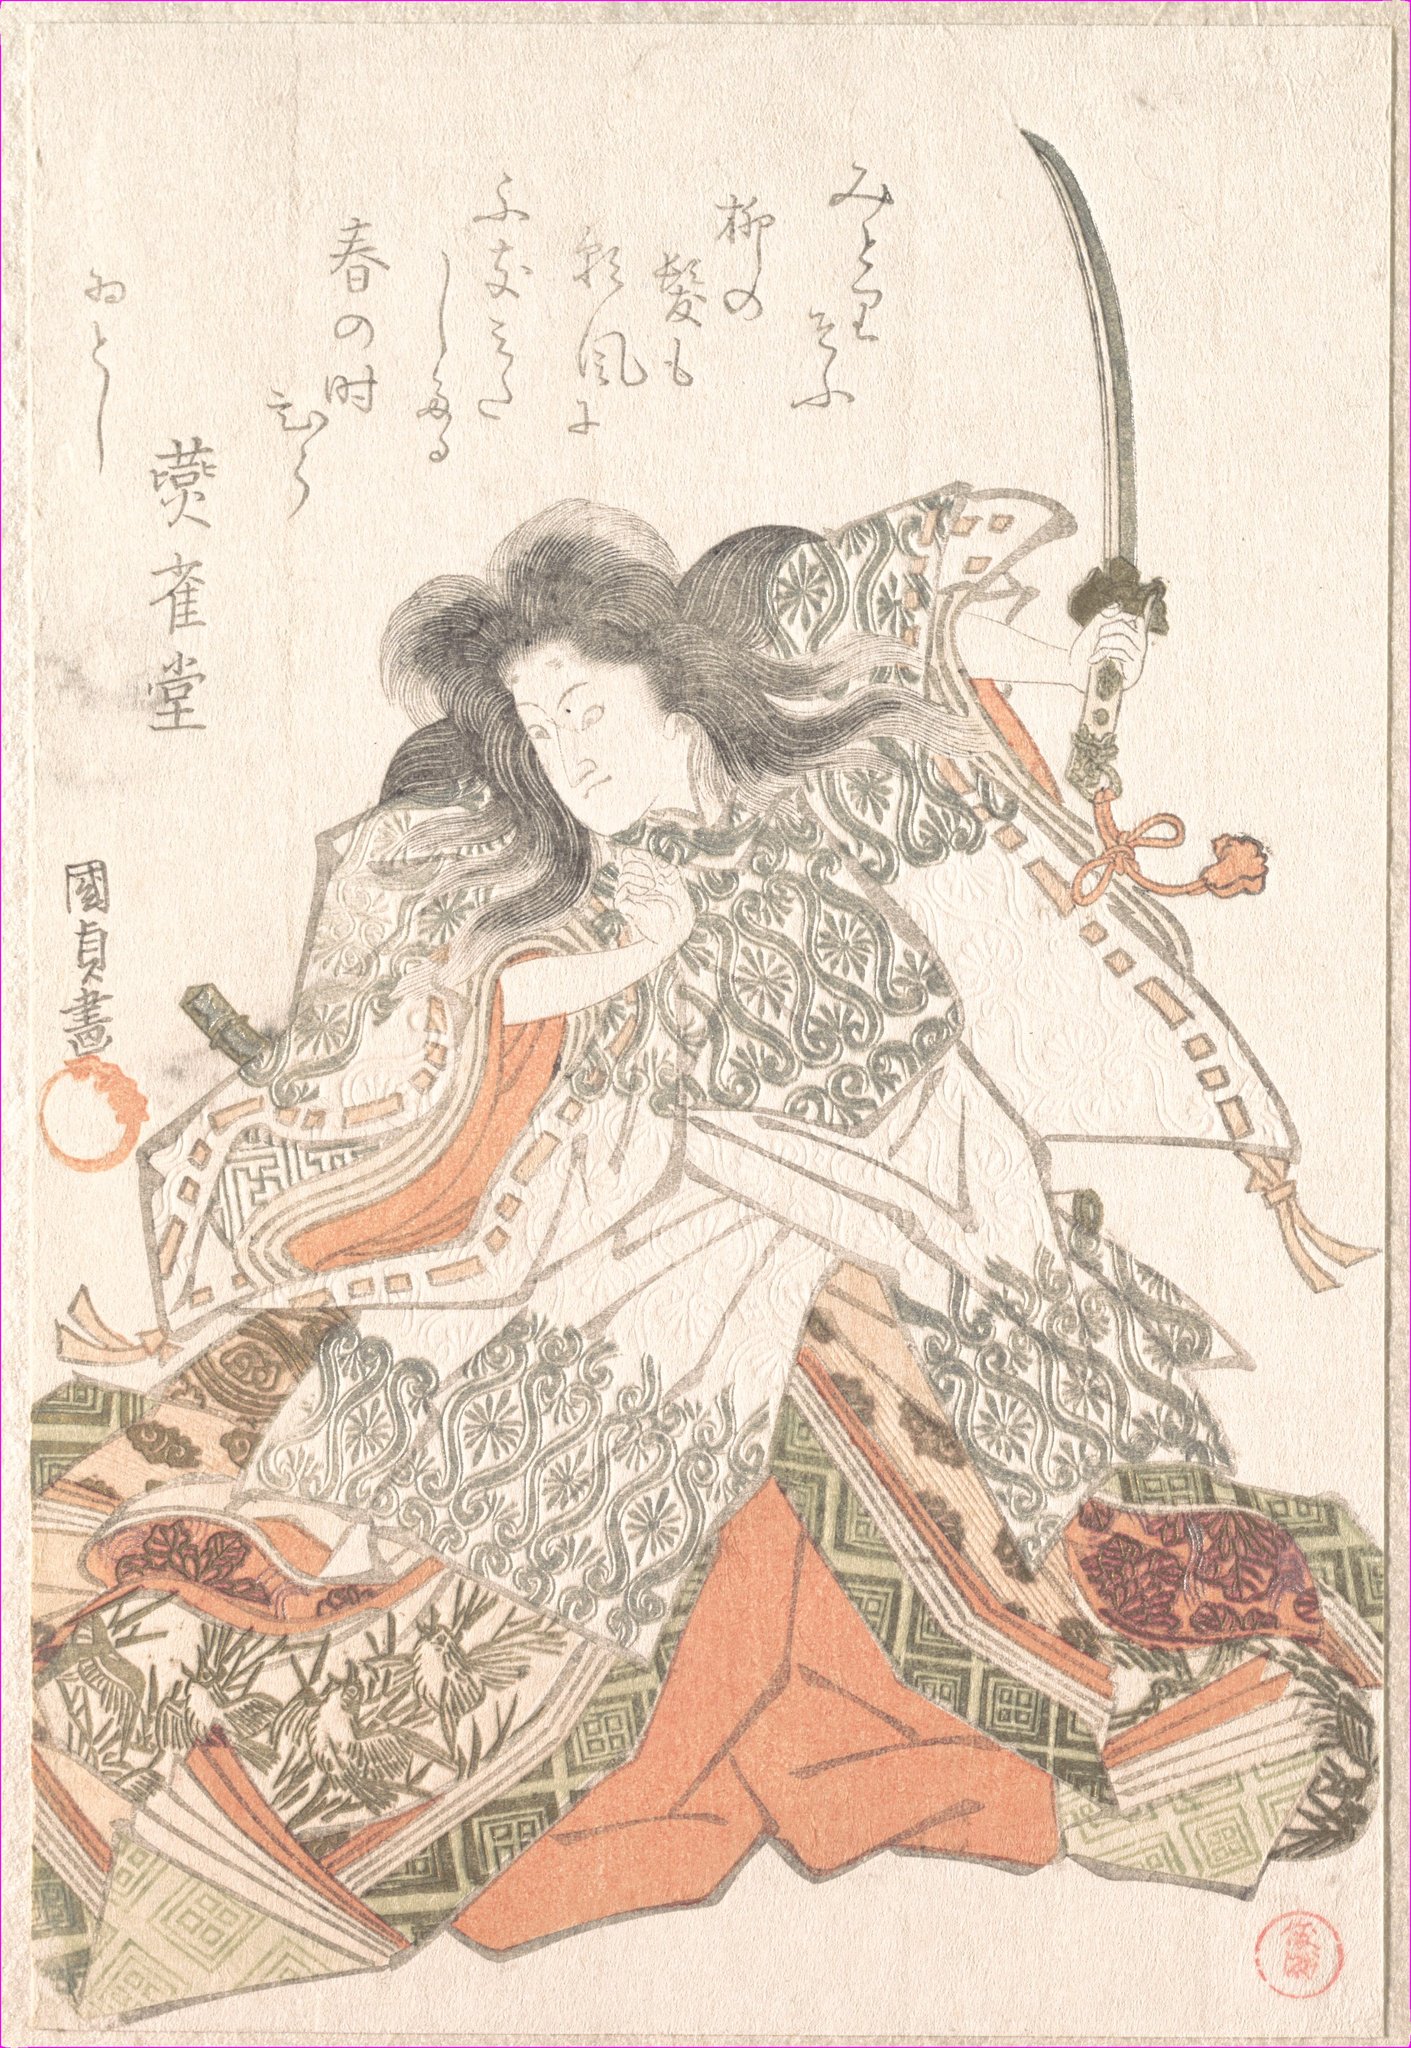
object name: print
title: Actor as Tokihira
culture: japanese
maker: utagawa kunisada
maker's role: artist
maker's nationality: japanese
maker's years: 1786-1864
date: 1815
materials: ink, paper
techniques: surimono, woodblock print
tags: swords,men,actors